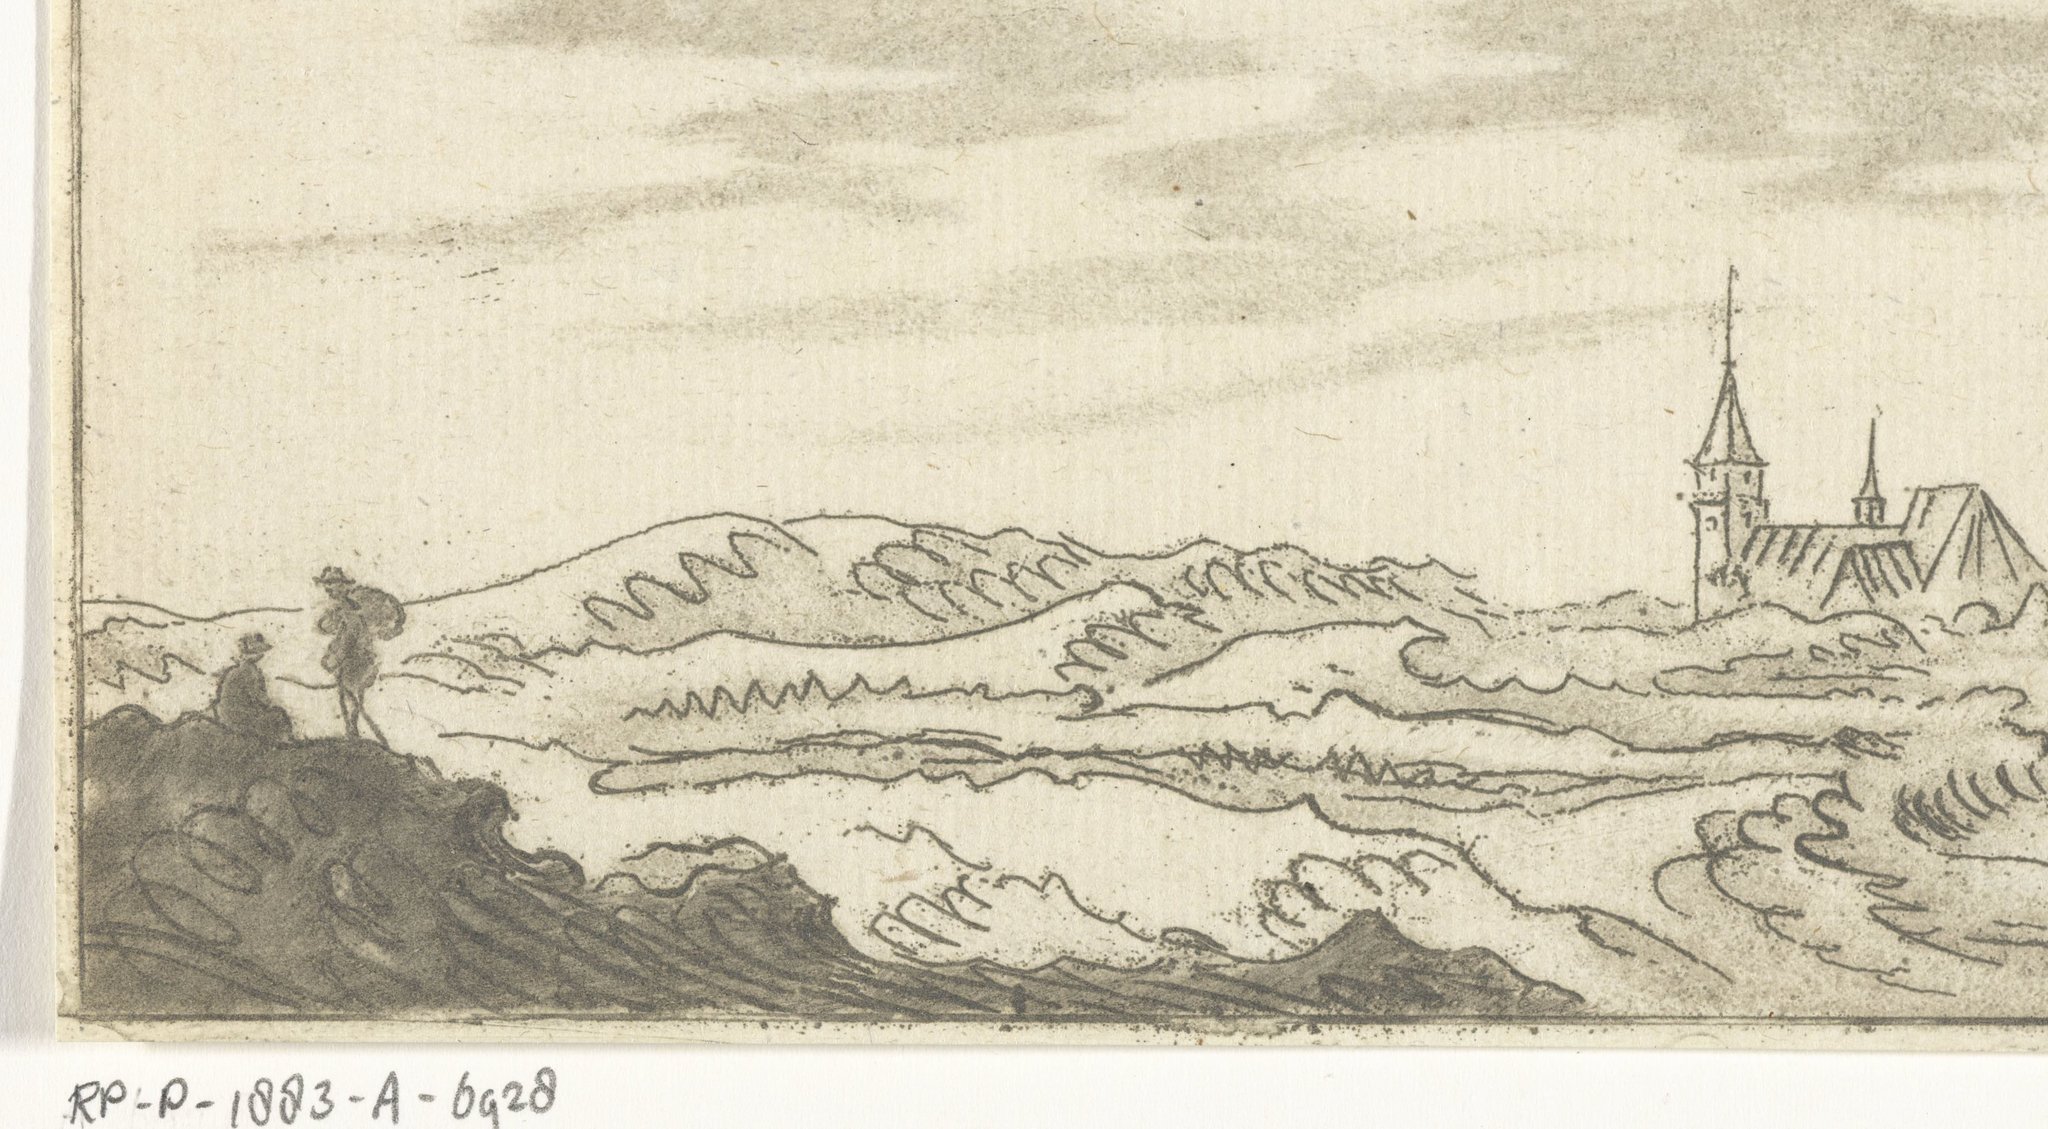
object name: print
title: Duinlandschap met een kerk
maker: cornelis van noorde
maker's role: draughtsman, print maker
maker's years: 1731-1795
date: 1767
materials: paper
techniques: printmaking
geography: haarlem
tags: church (exterior), dunes (sea not visible); in the dunes (+ landscape with figures, staffage)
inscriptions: collector's mark: Lugt 2228, inscription: ‘Na een tekening van J : v : Goyen in 't koper gebragt door Corn : van Noorde, 1767’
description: Een duinlandschap met links twee figuren en rechts een kerk.